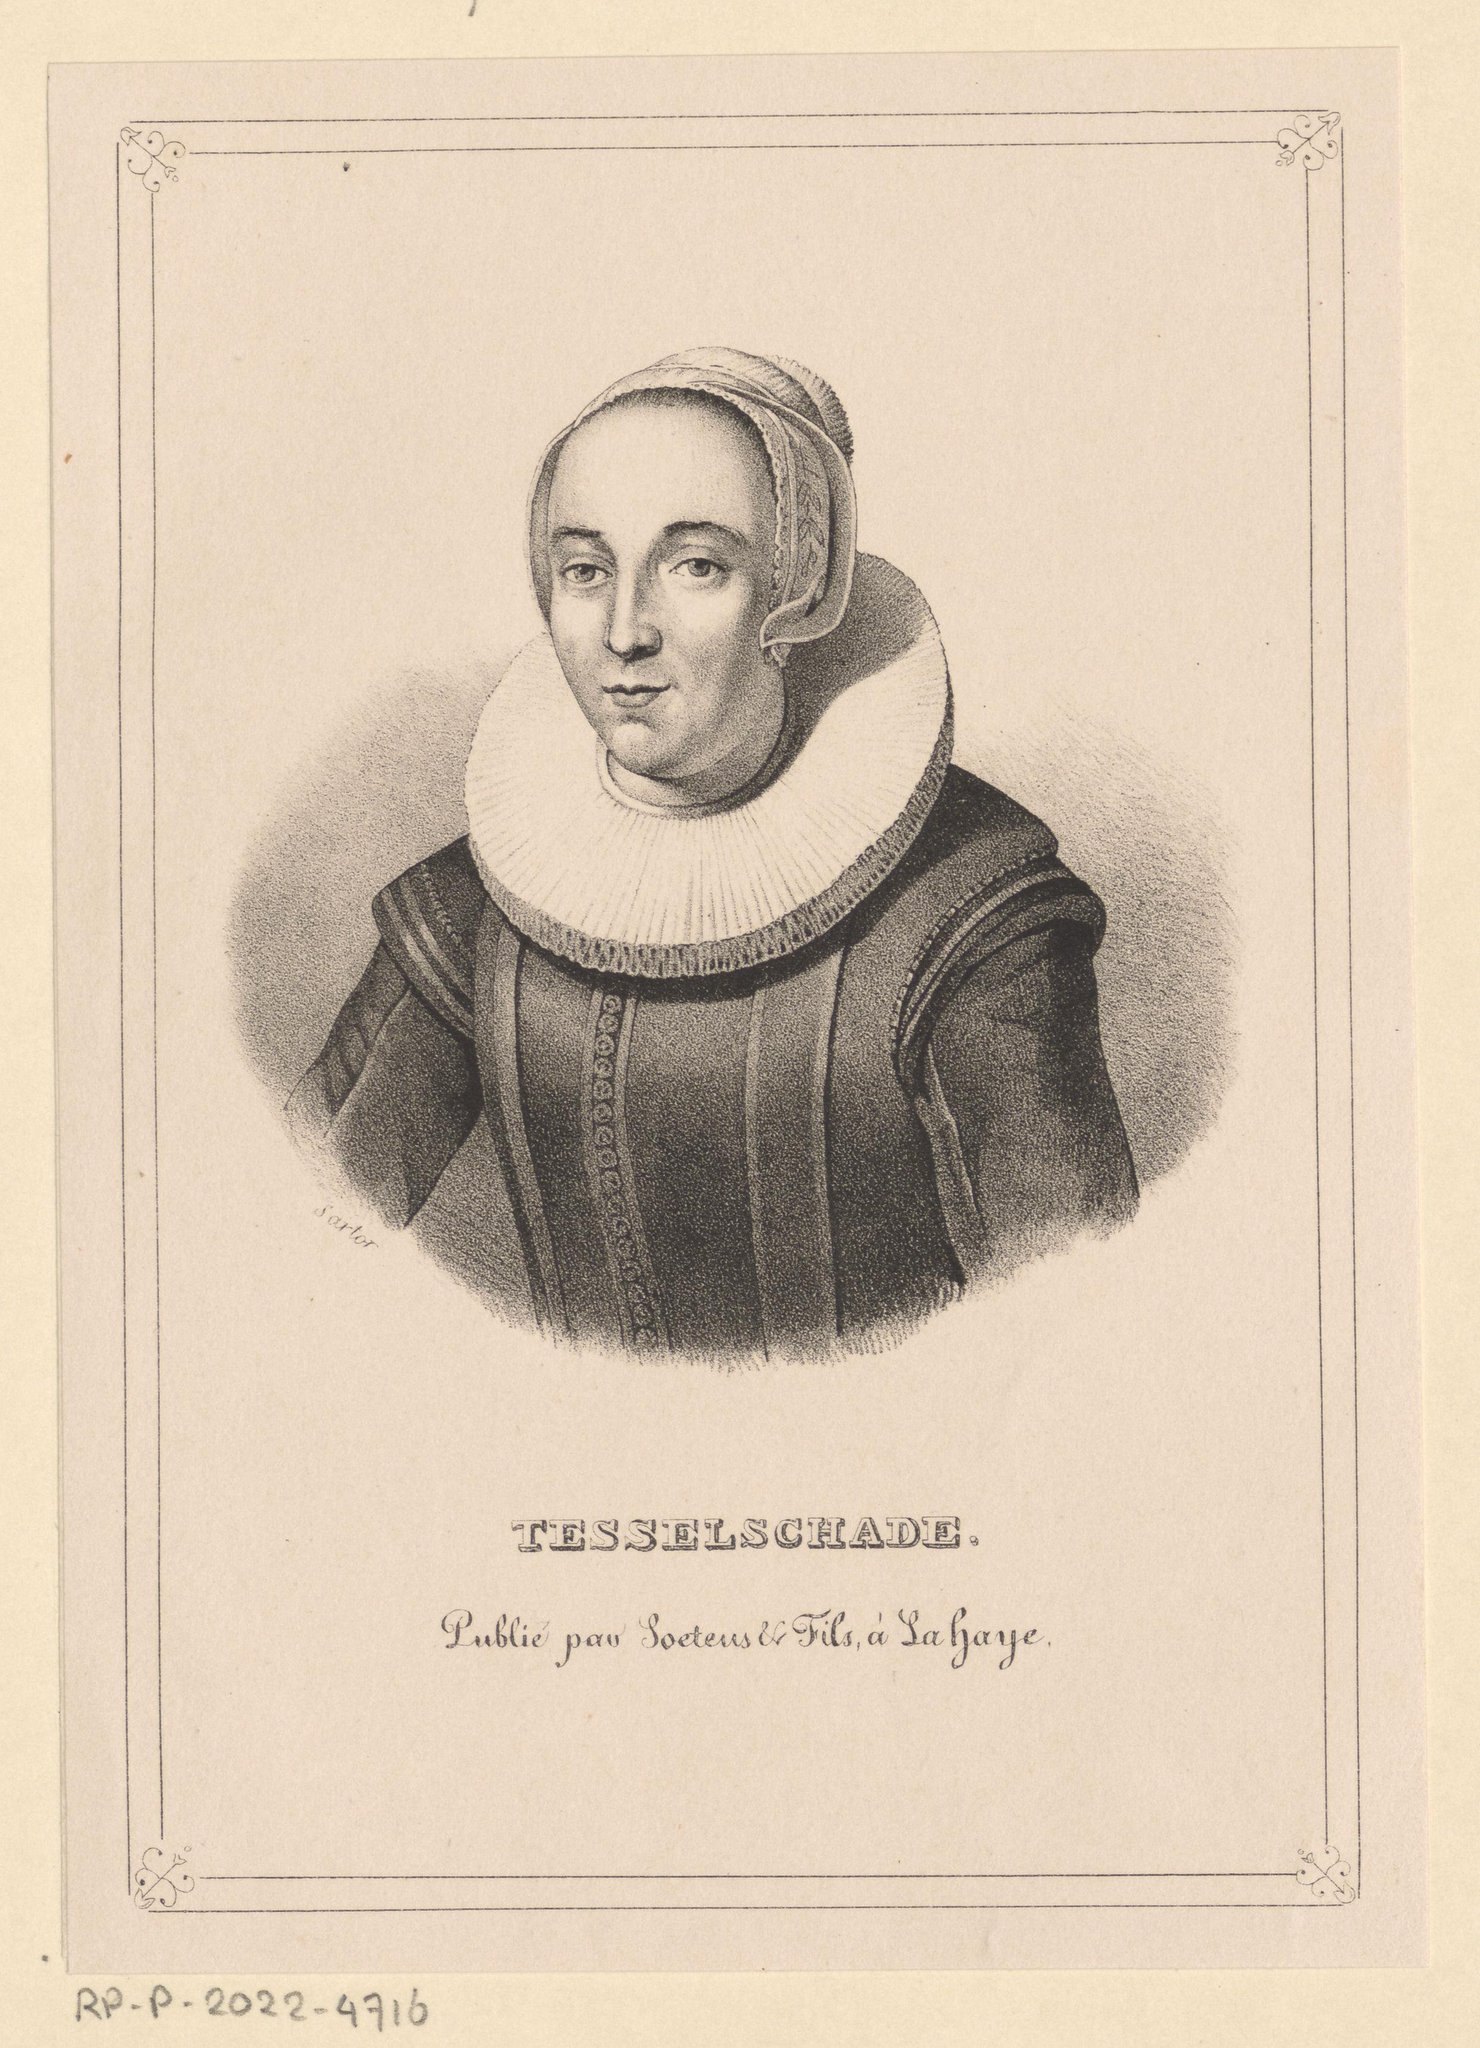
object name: print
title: Serie portretten door Soetens & Fils omstreeks 1838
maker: hendrik frederik sartor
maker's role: draughtsman, print maker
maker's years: 1818-1881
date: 1837-1840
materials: paper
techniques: lithograph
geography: amsterdam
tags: maria tesselschade roemers visscher, anonymous historical person portrayed alone - bb - woman